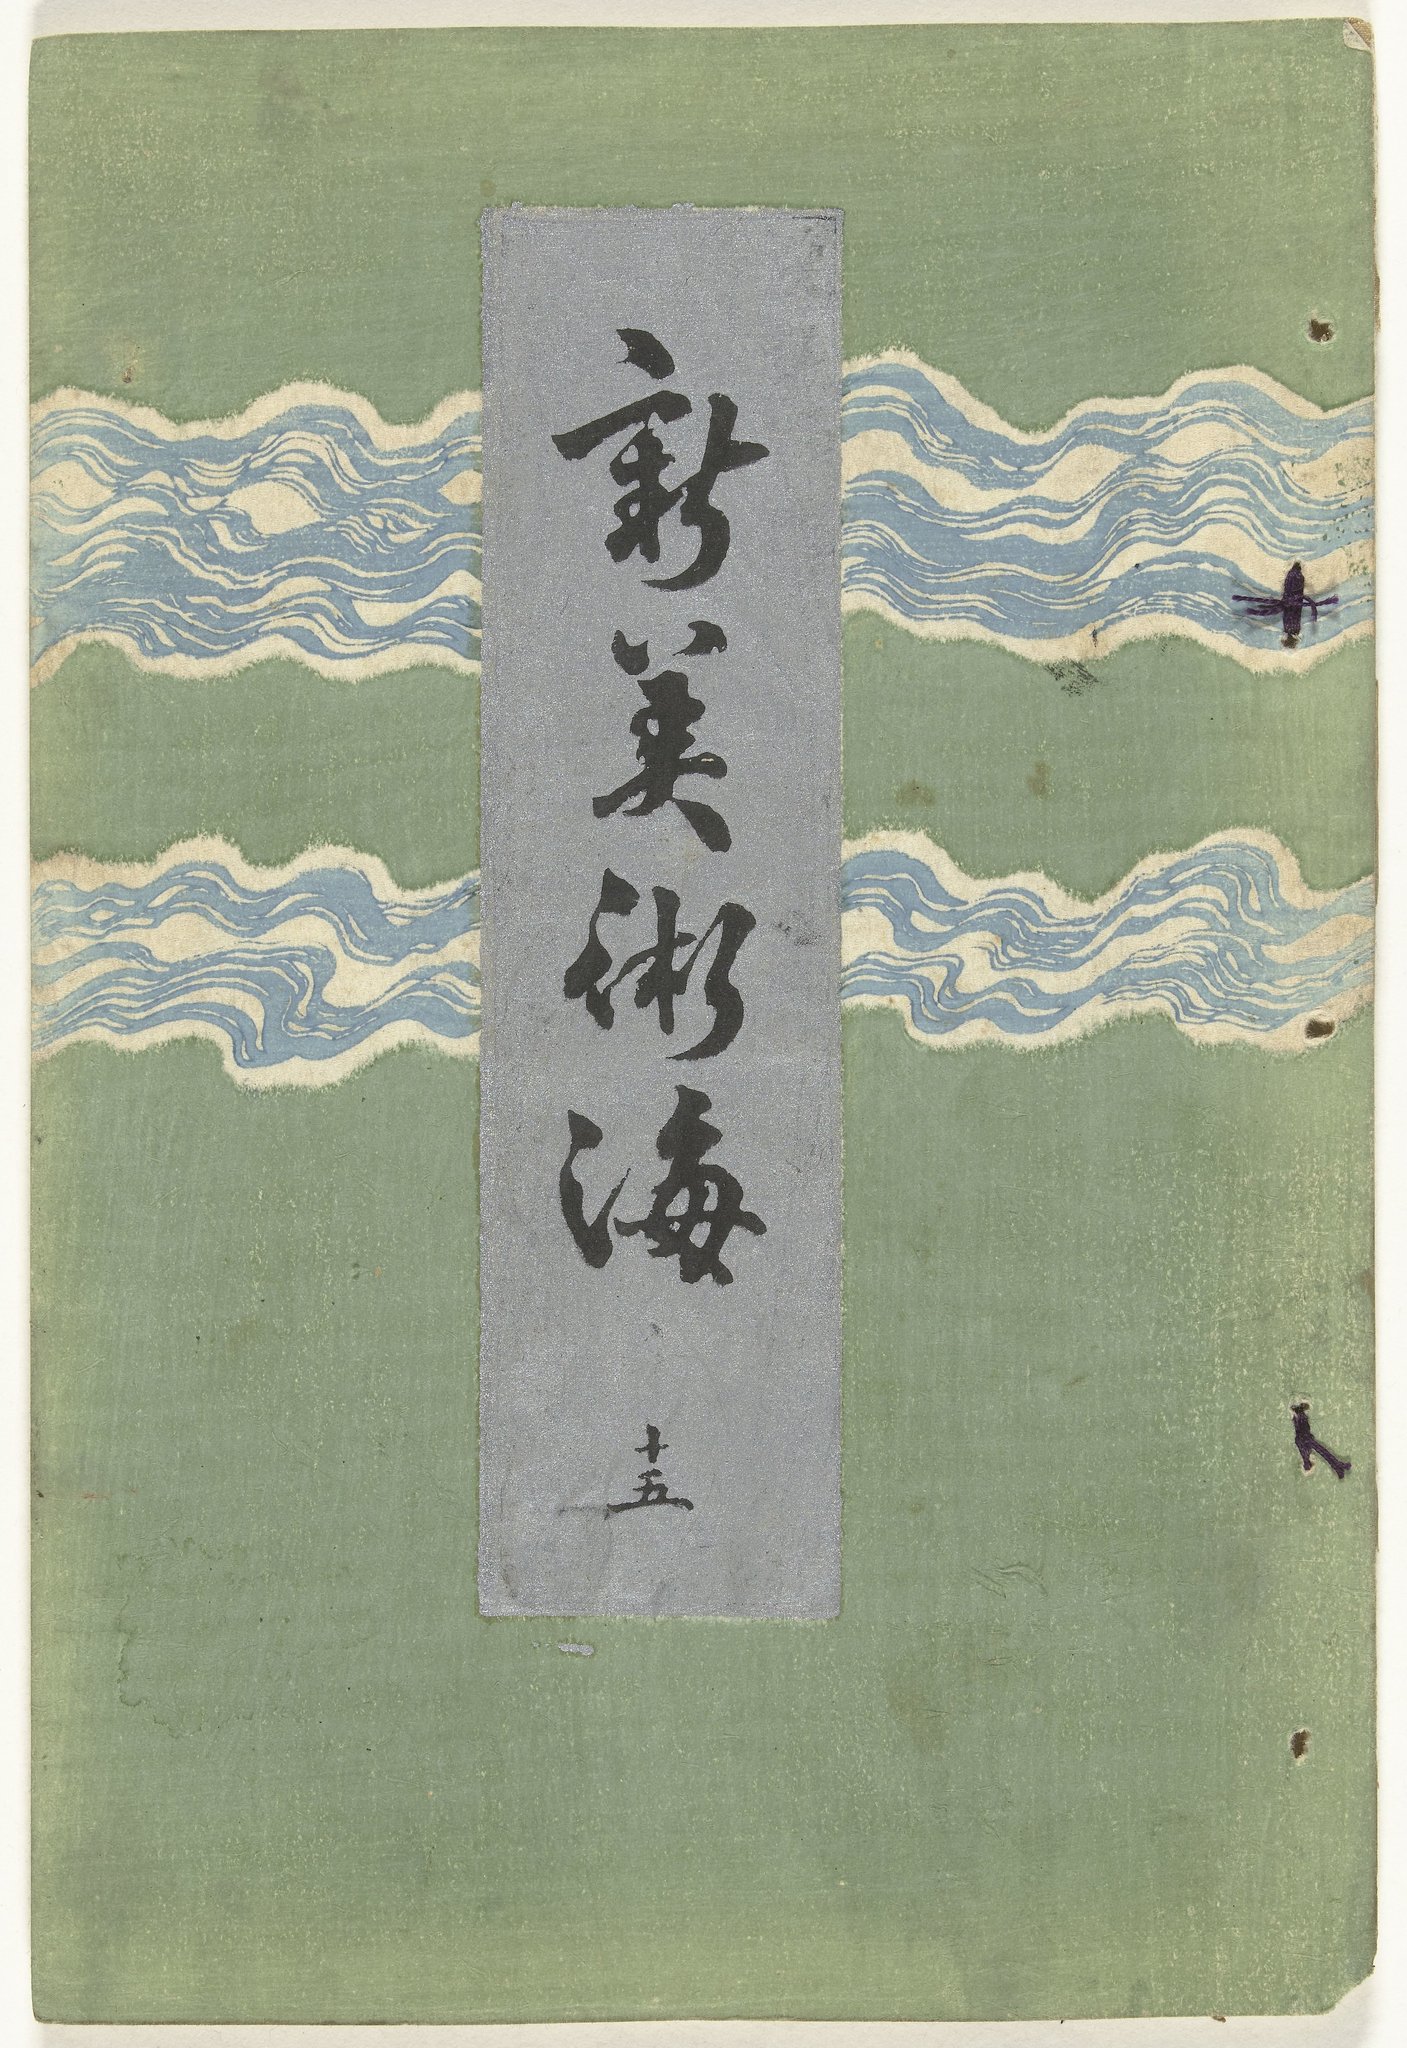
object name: book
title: Nieuwe zee der kunsten - 15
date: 1903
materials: gold powder, paper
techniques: woodcut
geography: kyoto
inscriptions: date